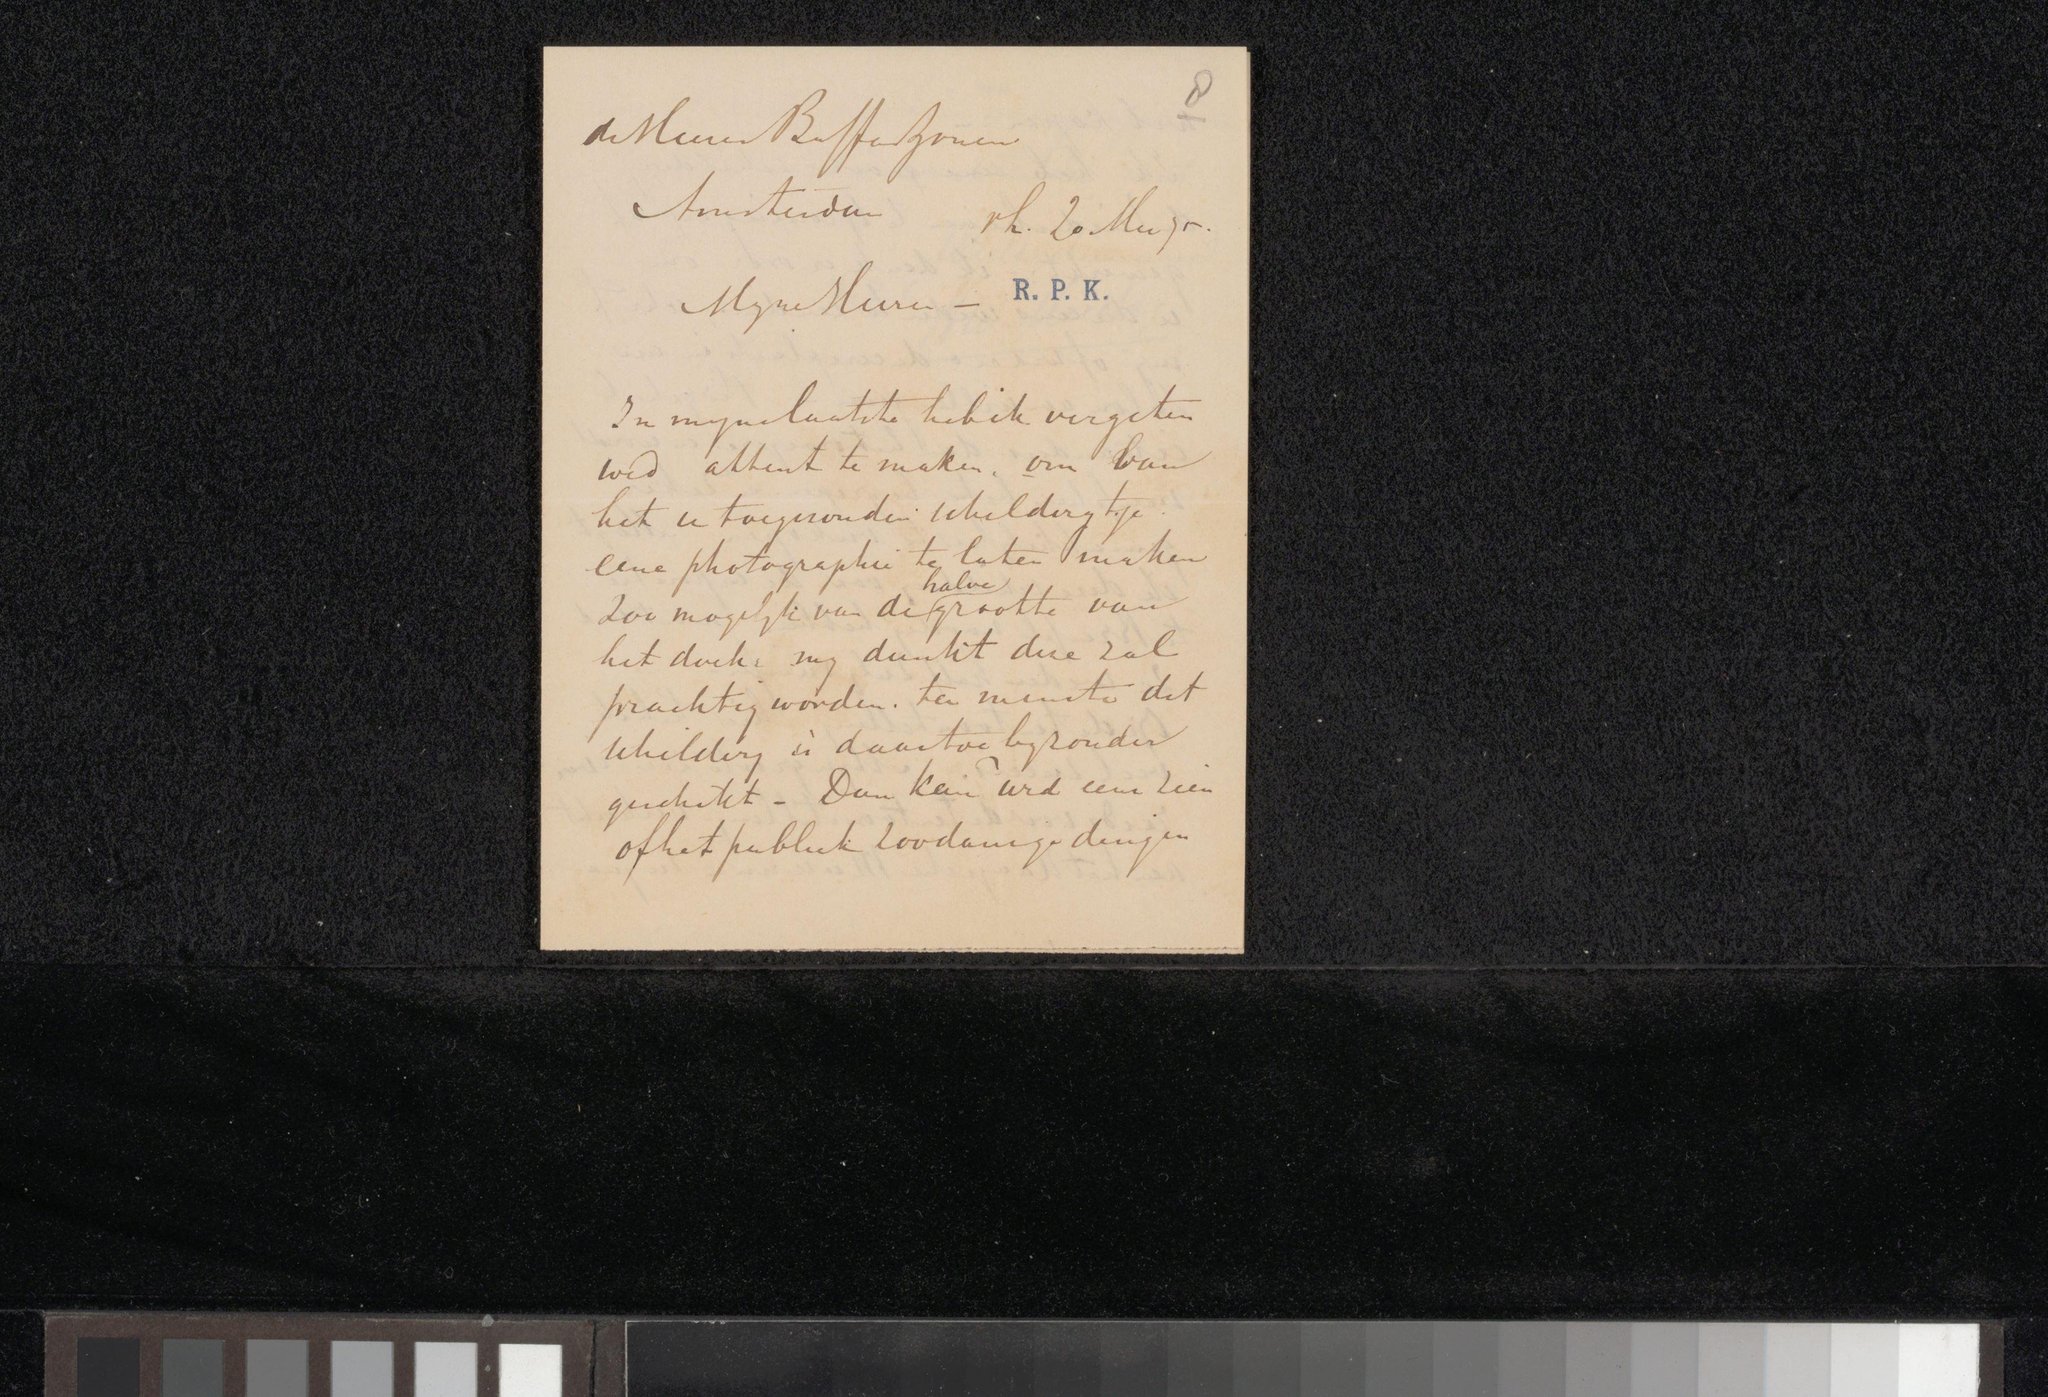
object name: letter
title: Brief aan Frans Buffa en Zonen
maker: hendrik willem mesdag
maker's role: draughtsman, painter, print maker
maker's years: 1831-1915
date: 1875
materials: ink, paper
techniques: pen, writing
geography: the hague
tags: delfshaven, rotterdam, gerke henkes, publisher, art trade, art shop, painting (including book-illumination, miniature-painting), exhibition ~ art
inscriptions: collector's mark: Lugt 2233